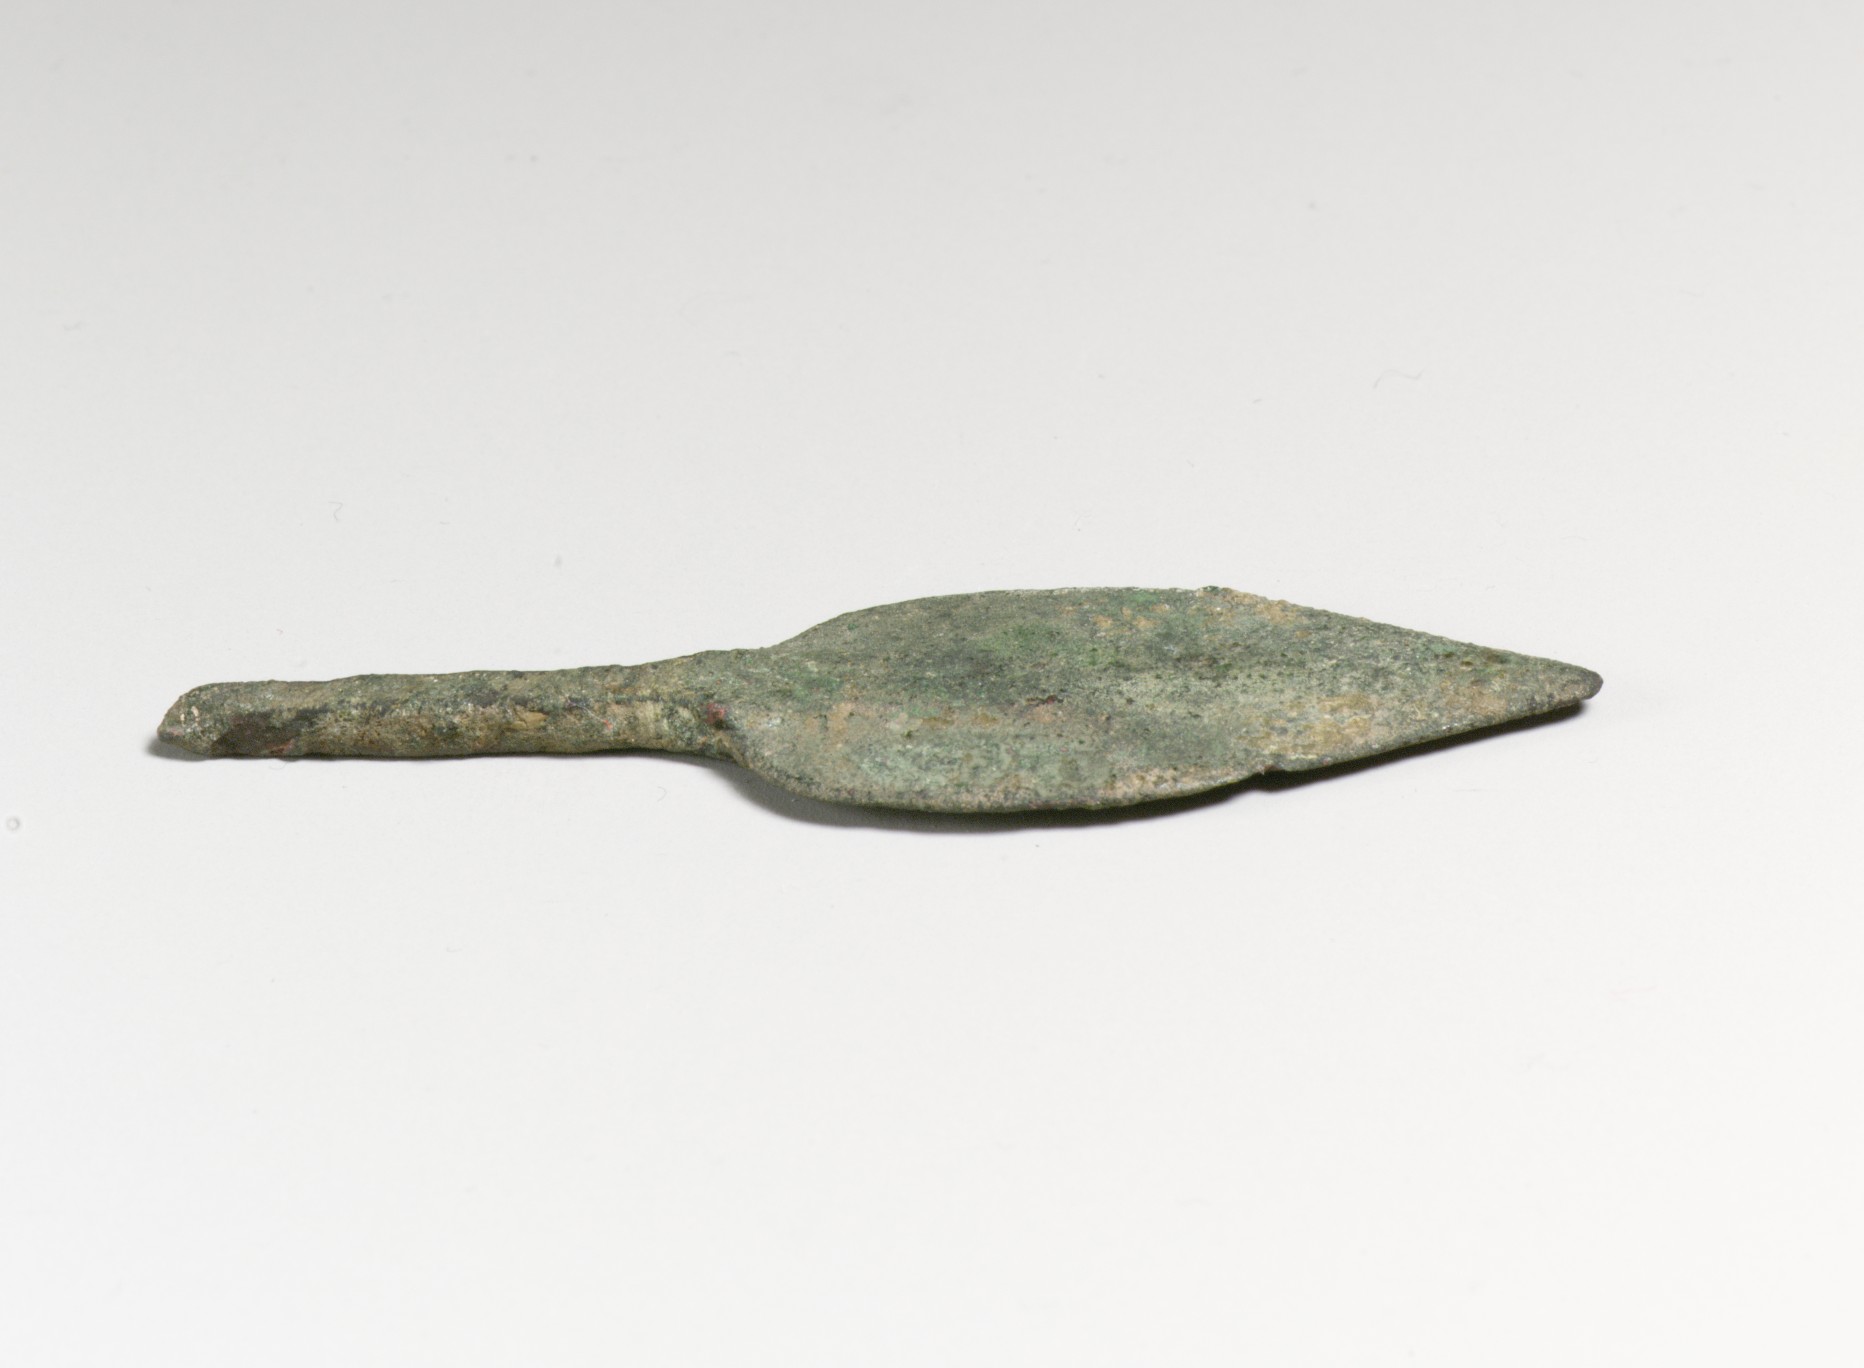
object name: arrowhead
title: Bronze arrowhead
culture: cypriot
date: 1600-1050 BCE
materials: bronze